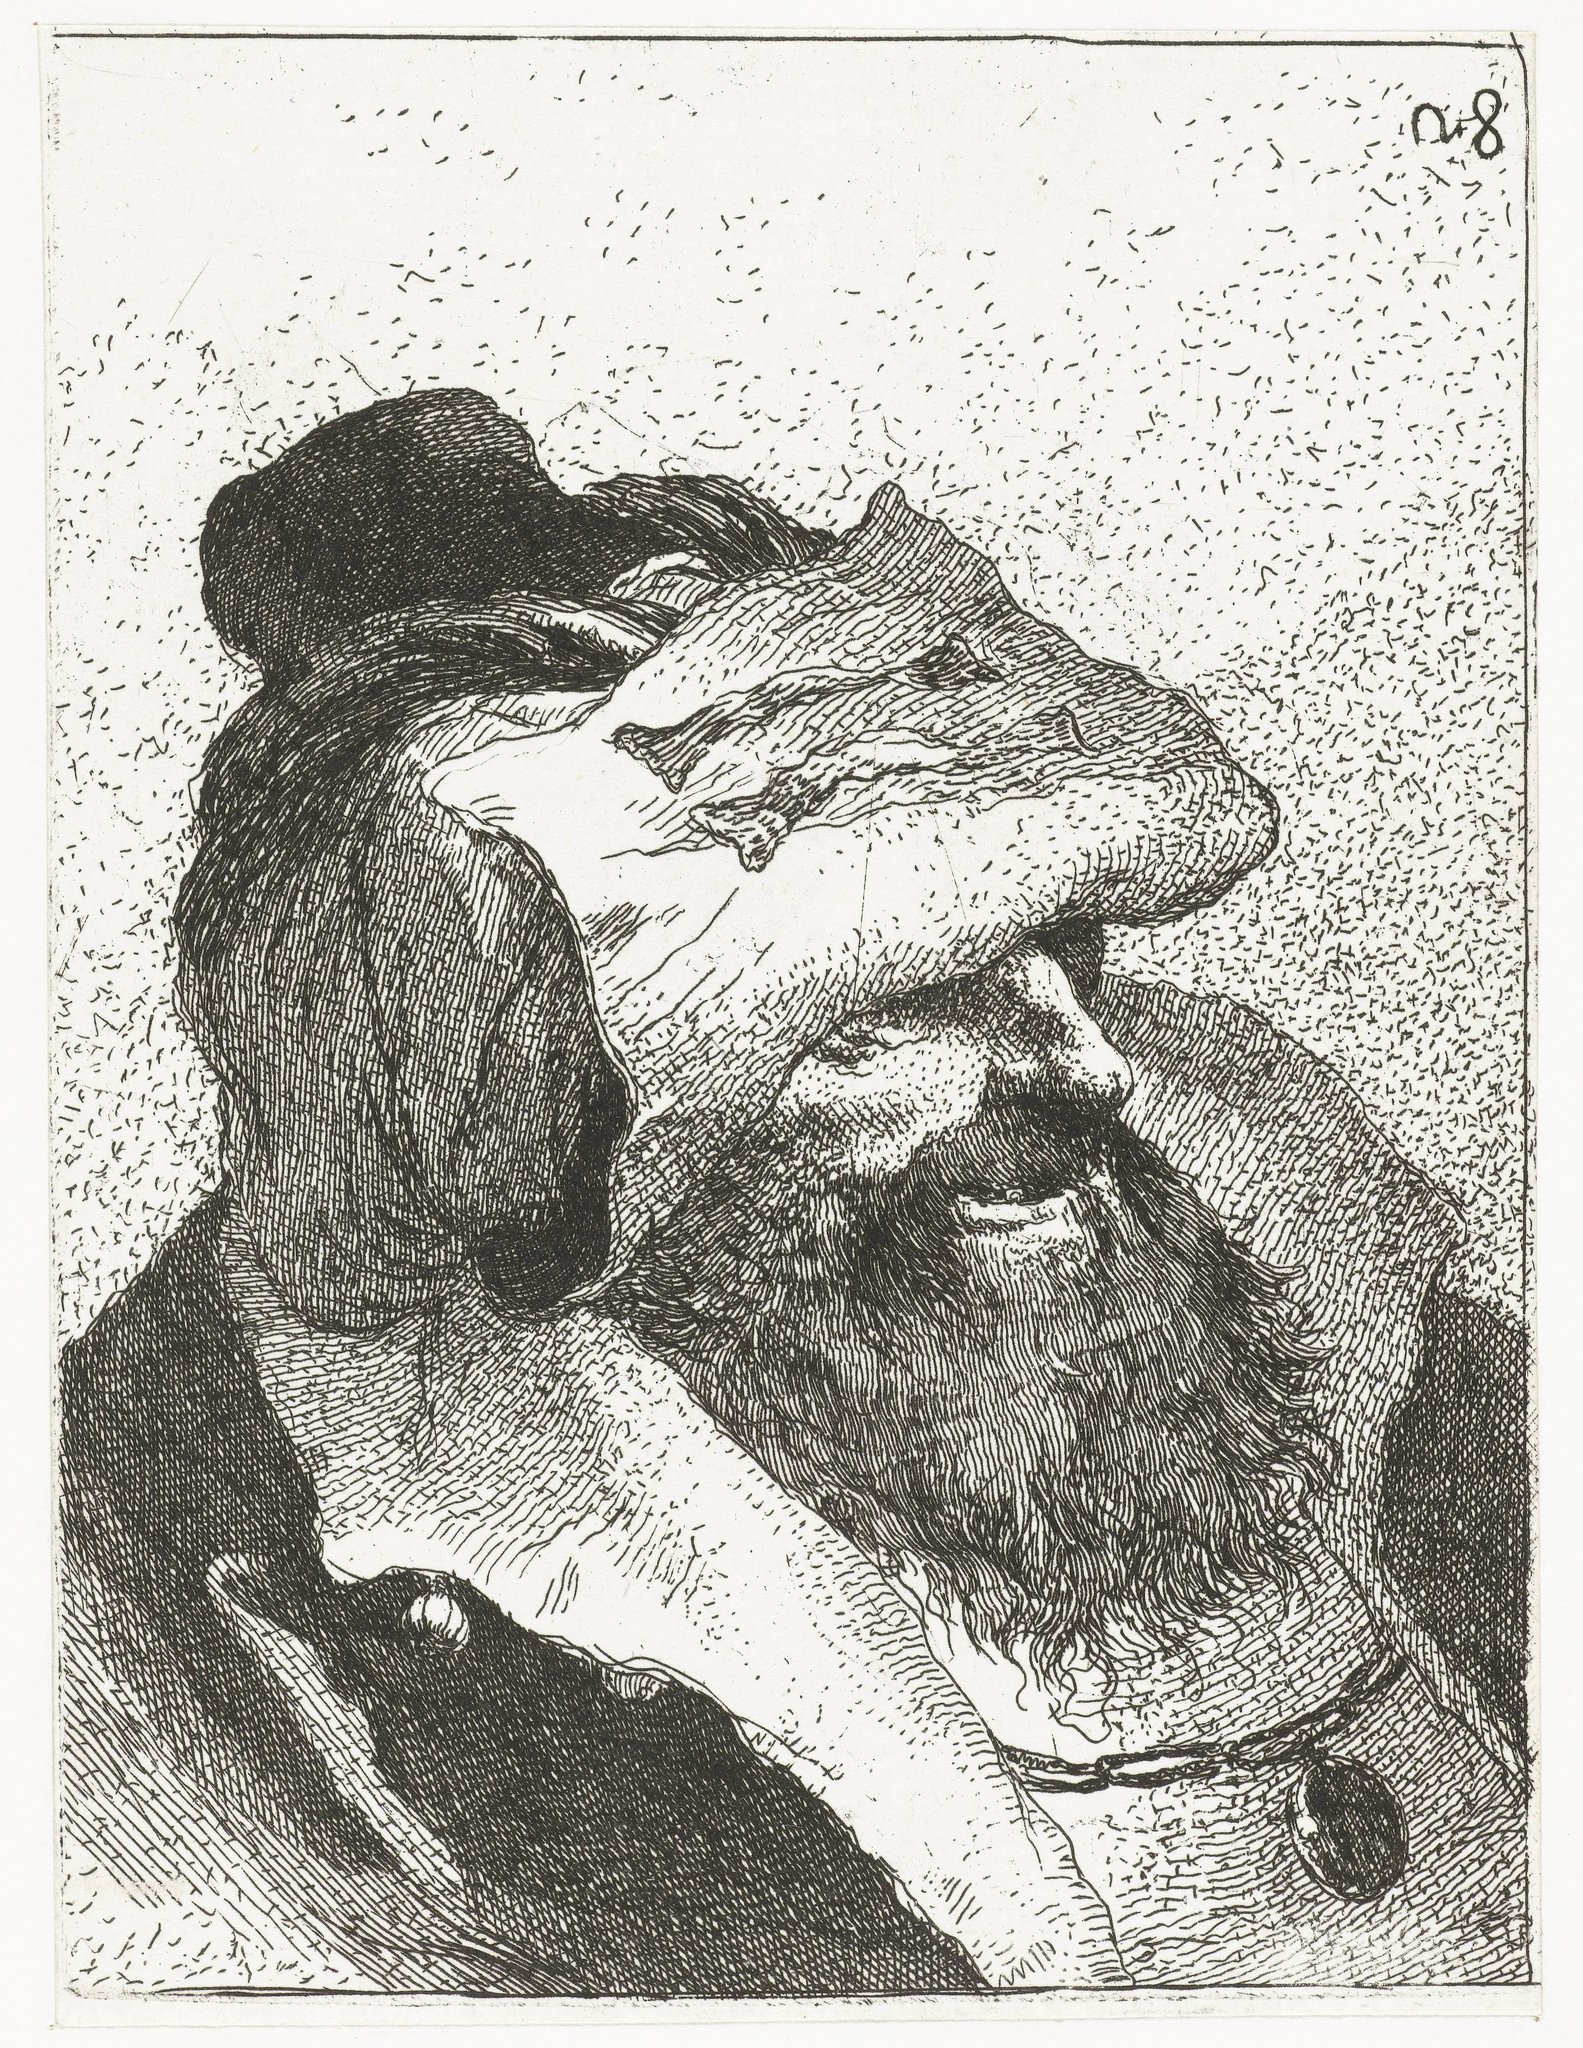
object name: print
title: Raccolta di Teste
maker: giovanni domenico tiepolo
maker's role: draughtsman, print maker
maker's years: 1727-1804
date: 1756-1757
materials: paper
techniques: etching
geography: venice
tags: head-gear: hat (+ men's clothes)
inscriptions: collector's mark: Lugt 2228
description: Prent uit serie Verzameling hoofden (Raccolta di teste). Giovanni Domenico Tiepolo vervaardigde in de winter van 1757-1758 en in de periode van 1771-1774 deze hoofden naar schilderijen en tekeningen van Giovanni Battista Tiepolo. De eerste uitgave verscheen in 1774 in twee delen met elk dertig prenten. Deze prent werd opgenomen in deel 1.